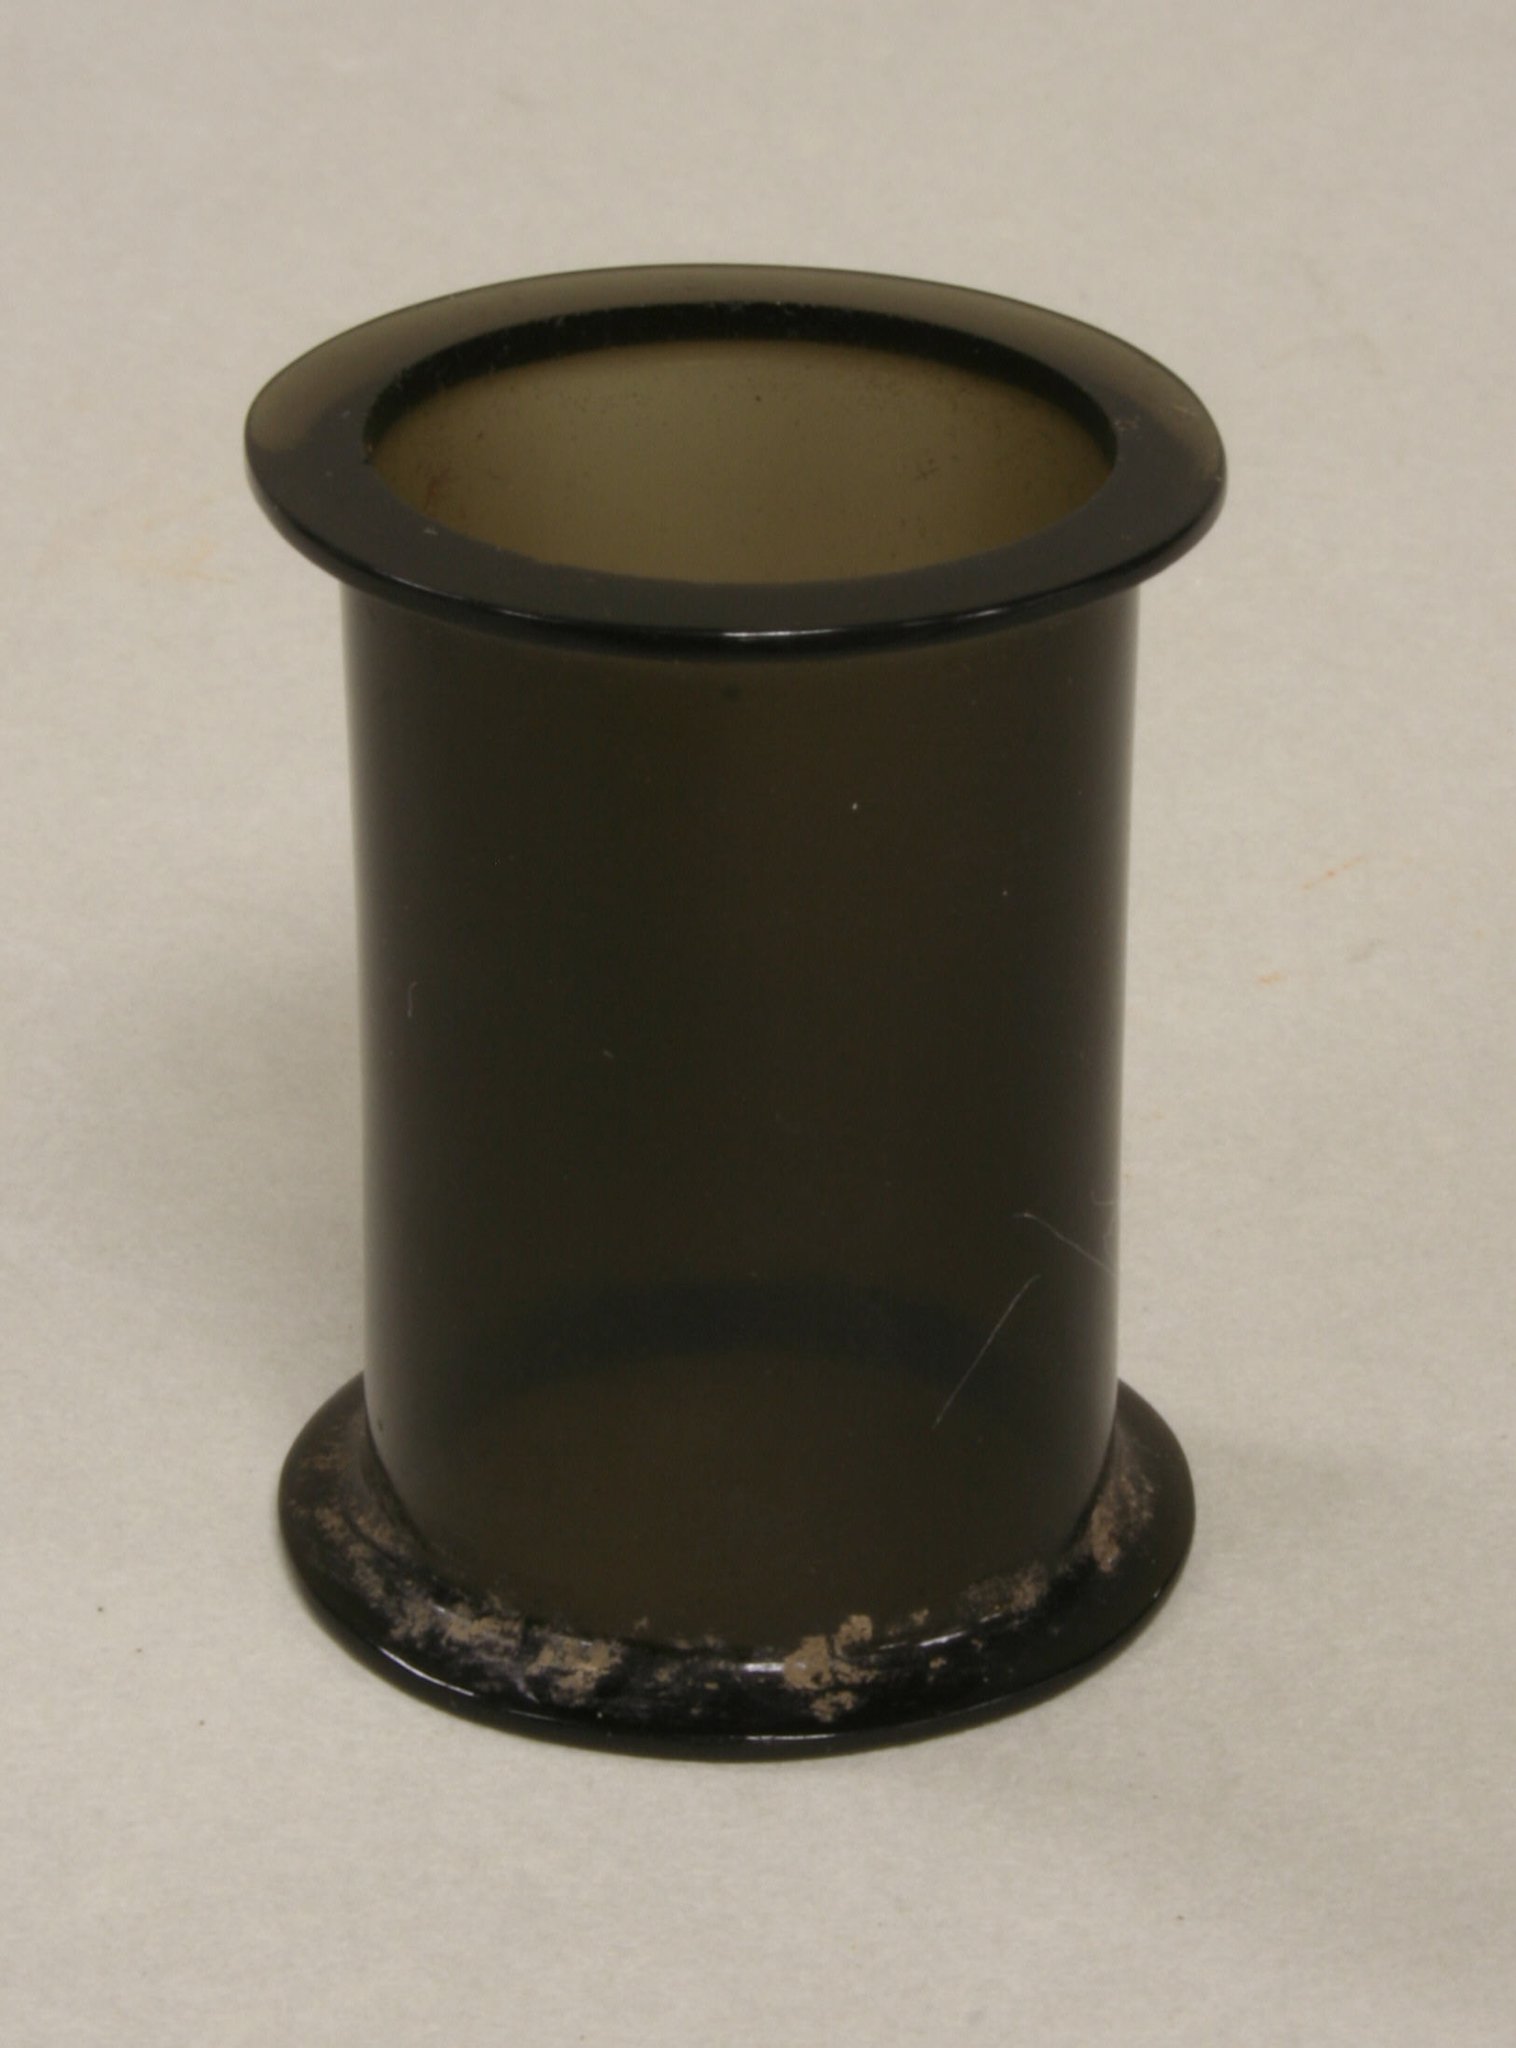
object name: ear ornament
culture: mexica, aztec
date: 1401-1600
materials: obsidian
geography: mexico